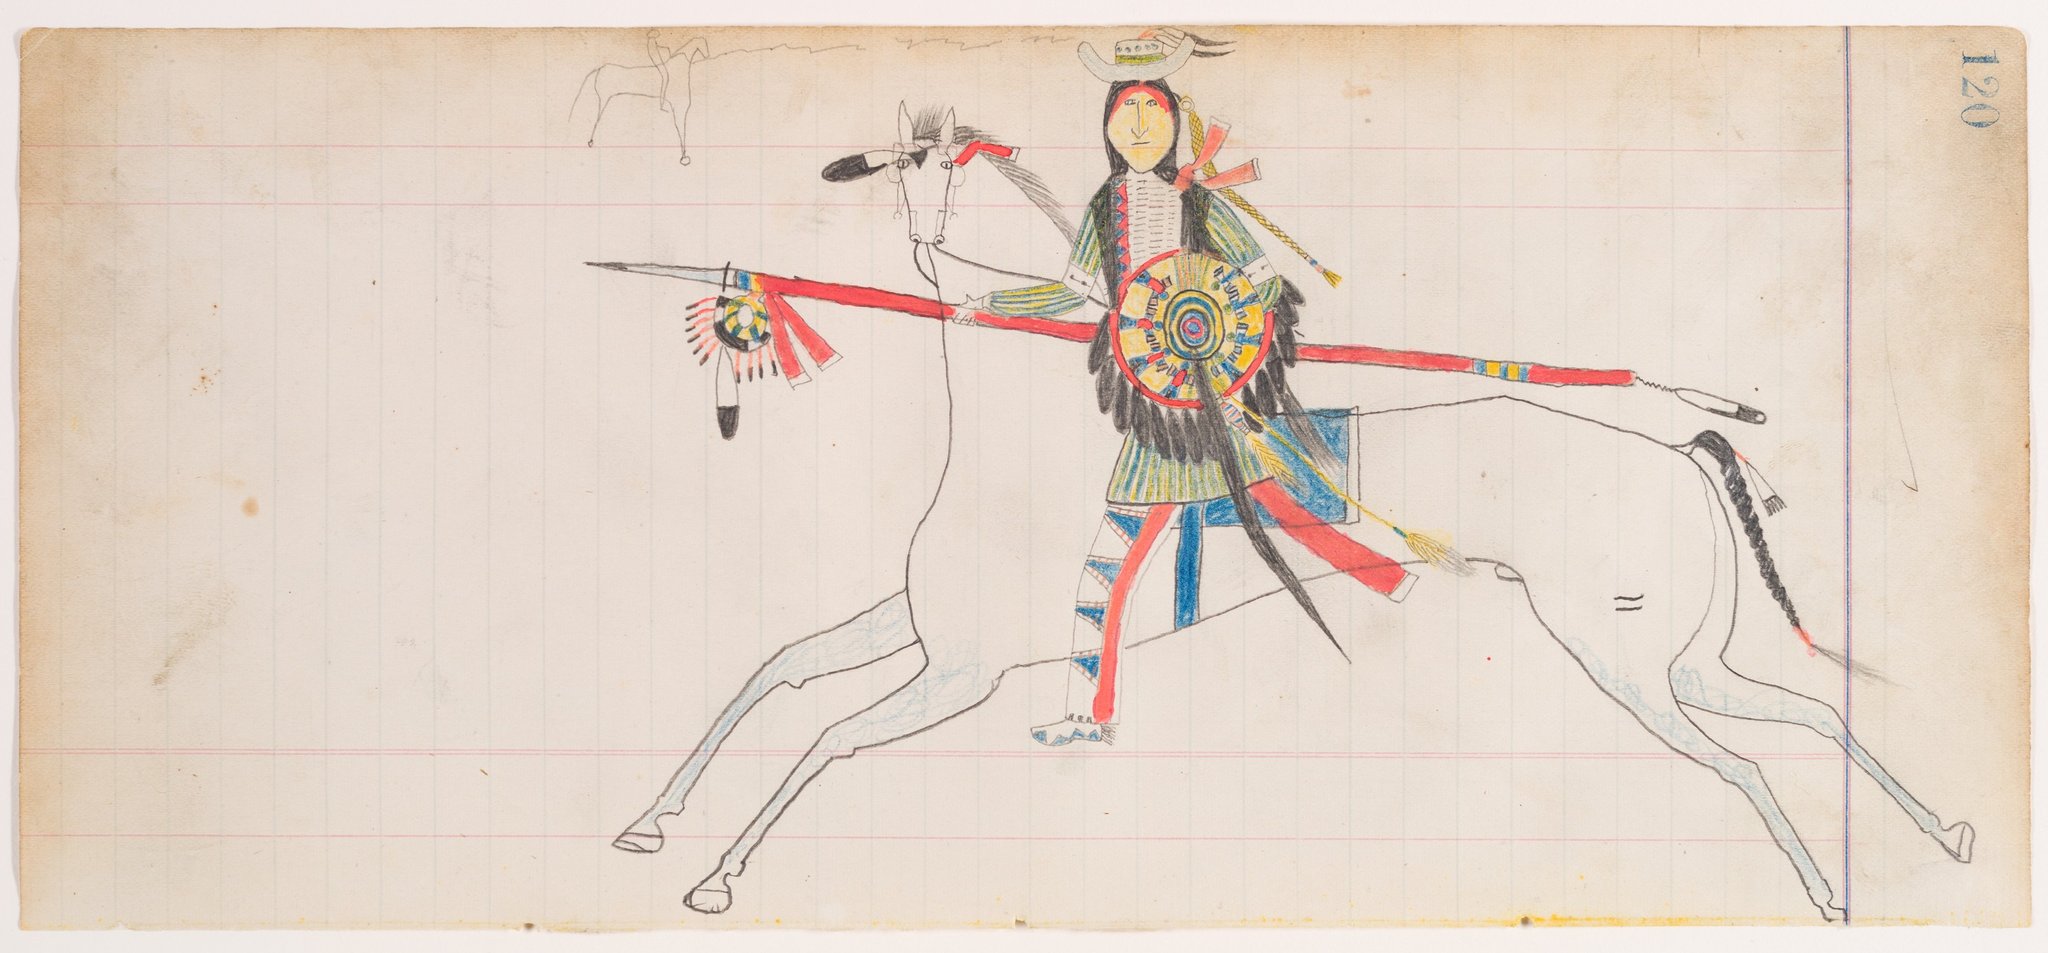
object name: drawing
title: Self-Portrait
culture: arapaho, southern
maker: henderson ledger artist a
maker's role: artist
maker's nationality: southern arapaho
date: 1880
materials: ink, paper, pencil, watercolor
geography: united states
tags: spears,men,horses